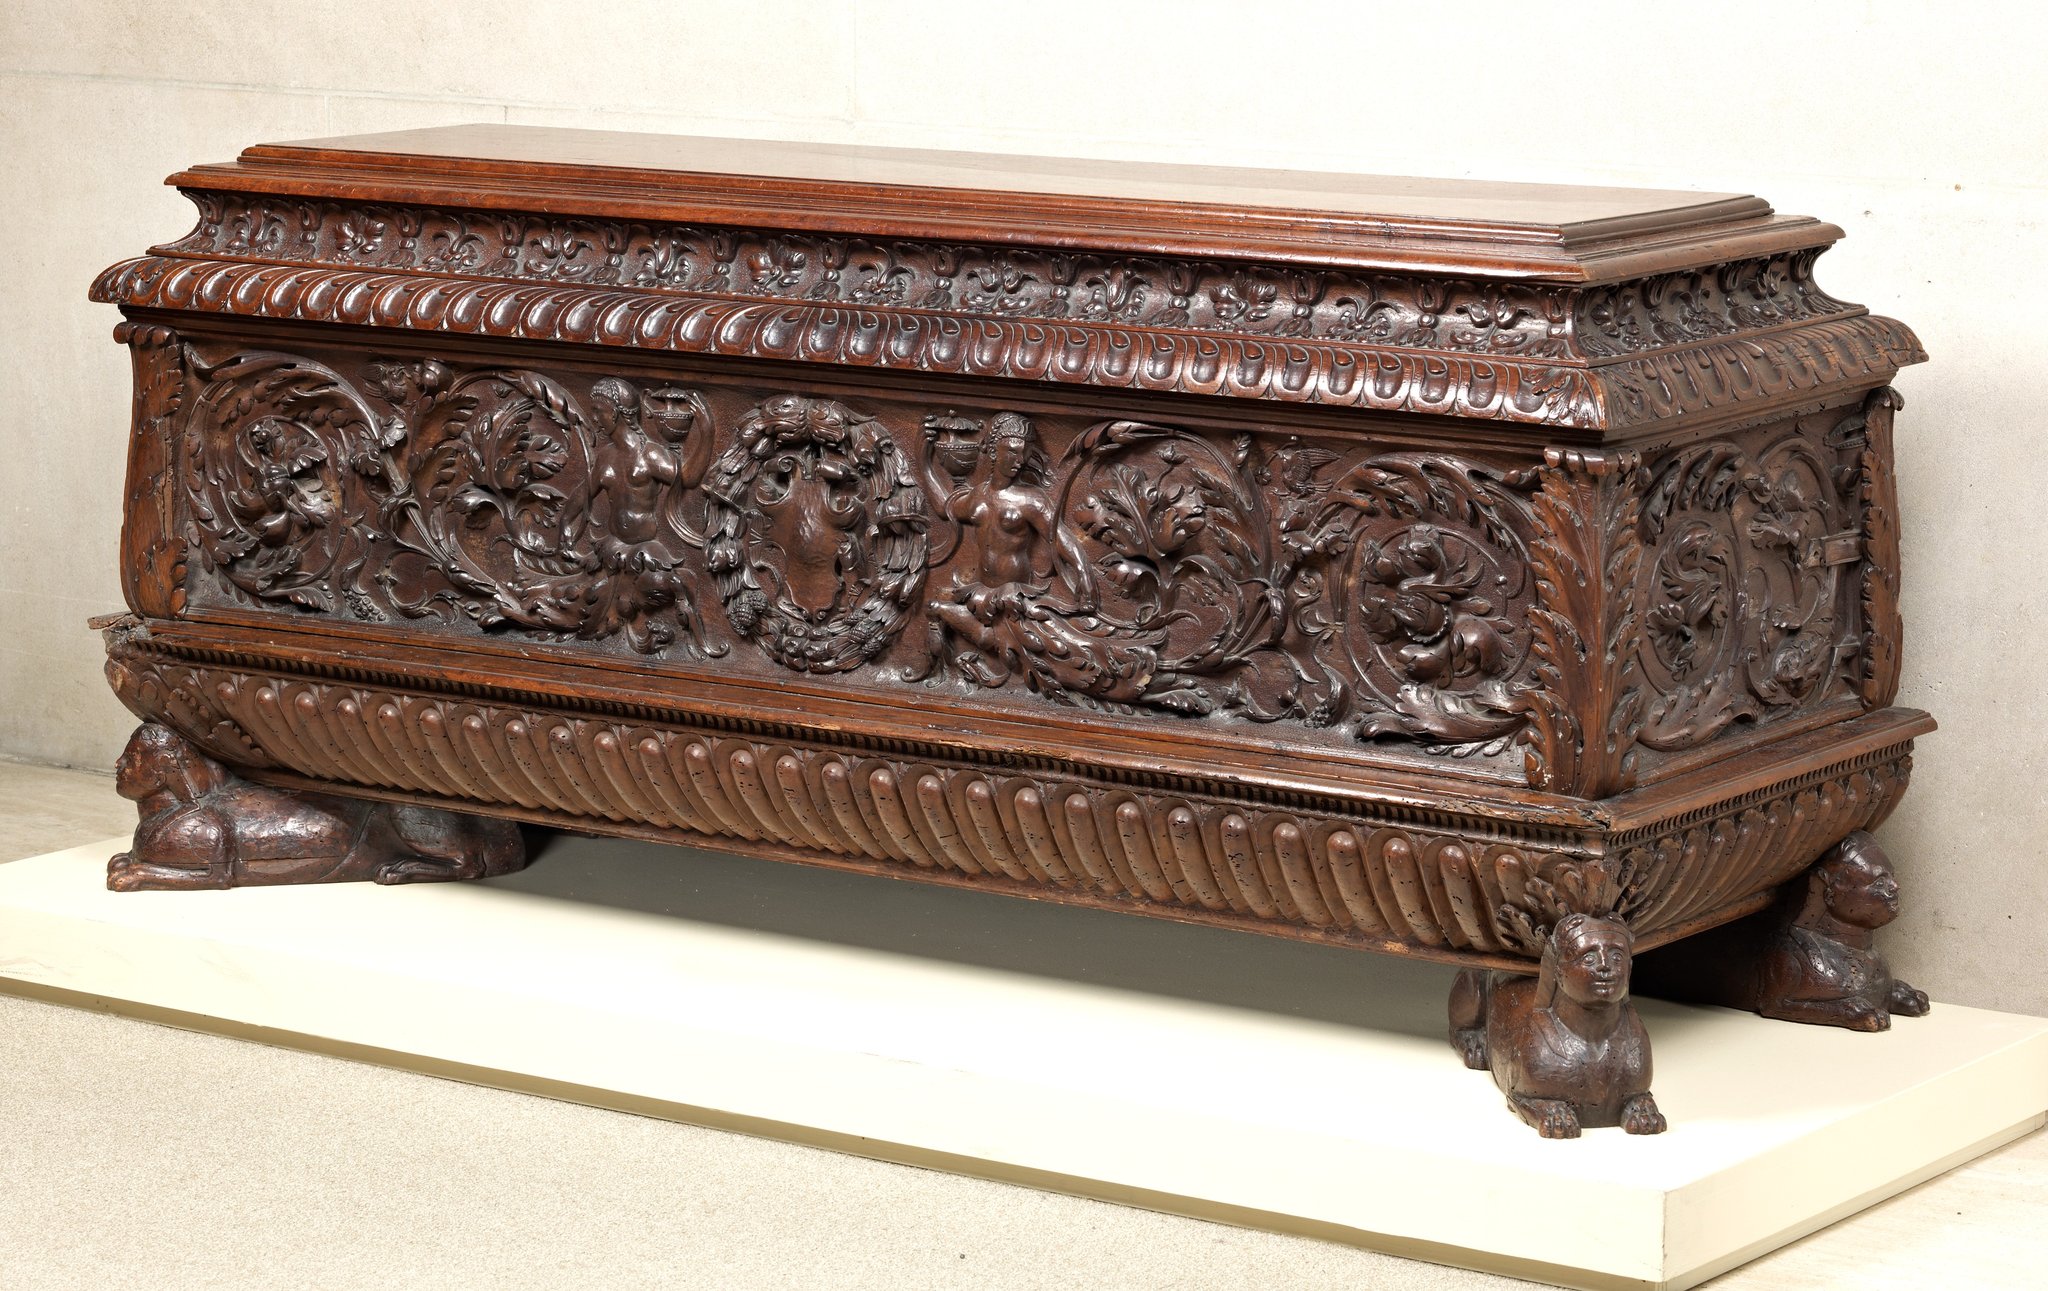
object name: cassone chest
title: Cassone (chest, pair with 1975.1.1945)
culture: italian, tuscany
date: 1840-1880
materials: wood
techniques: carving, gilding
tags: sphinx